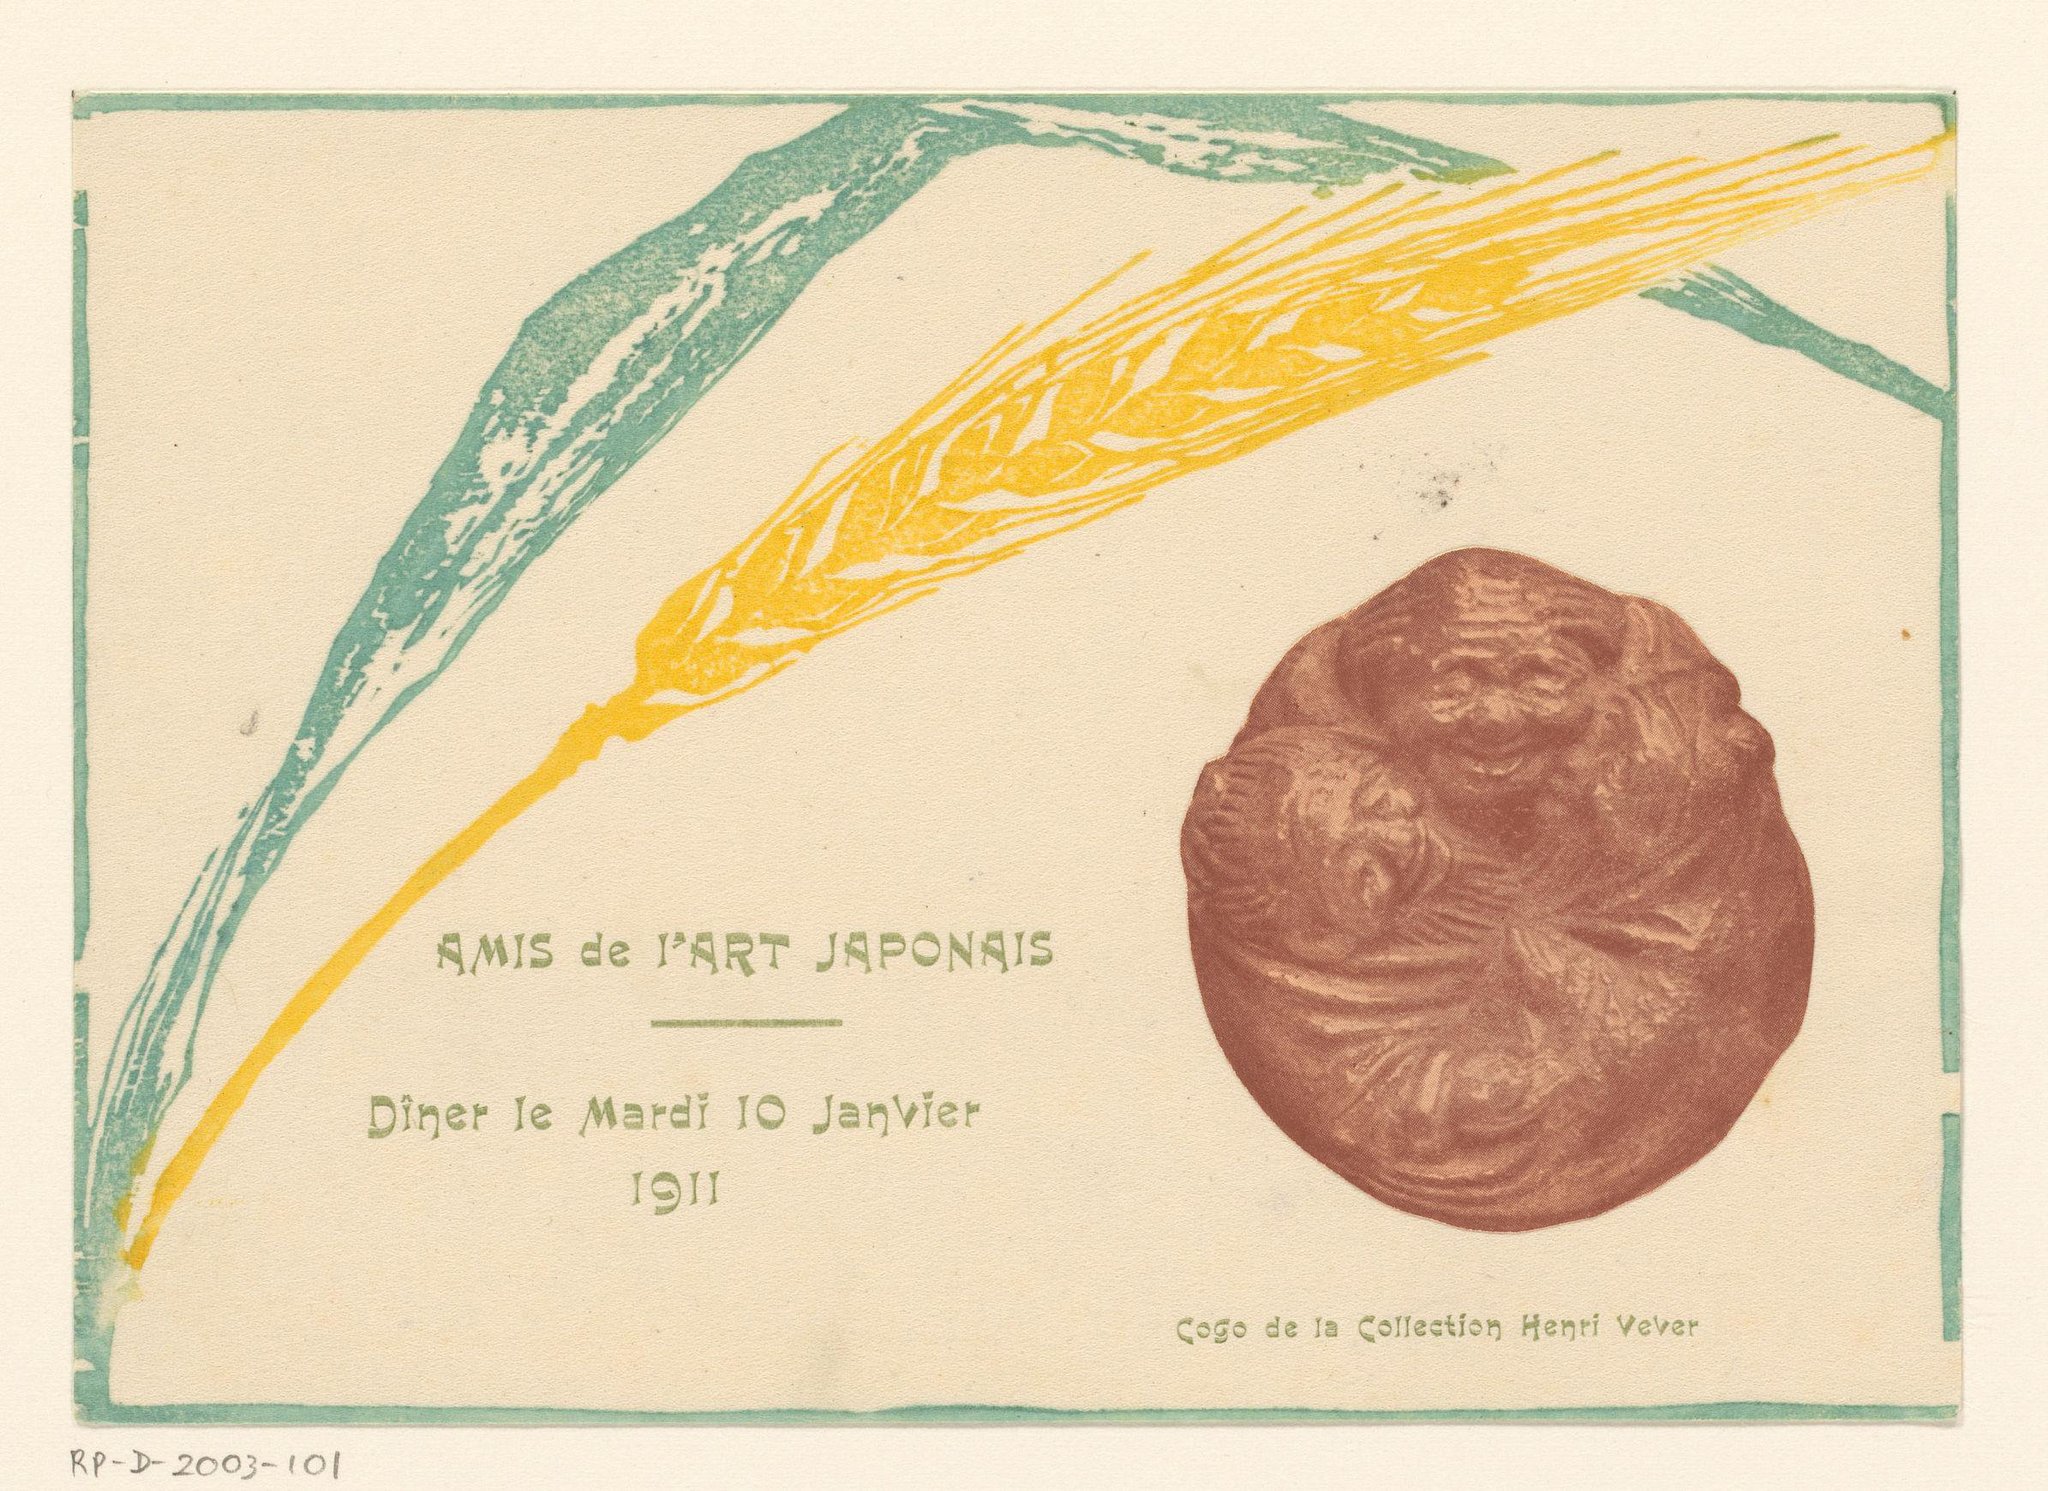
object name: print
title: Uitnodiging voor een diner van Les Amis de l'Art Japonais, 10 januari 1911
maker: Anonymous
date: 1901-1911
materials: paper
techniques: woodcut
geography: france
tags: plants and herbs: wheat, piece of sculpture, reproduction of a piece of sculpture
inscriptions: collector's mark: Lugt 2228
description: Tarwehalm met blad en een rond beeldje (netsuke?) uit de collectie van Henri Verver. Uitnodiging voor een diner van Les Amis de l'Art Japonais, 10 januari 1911.